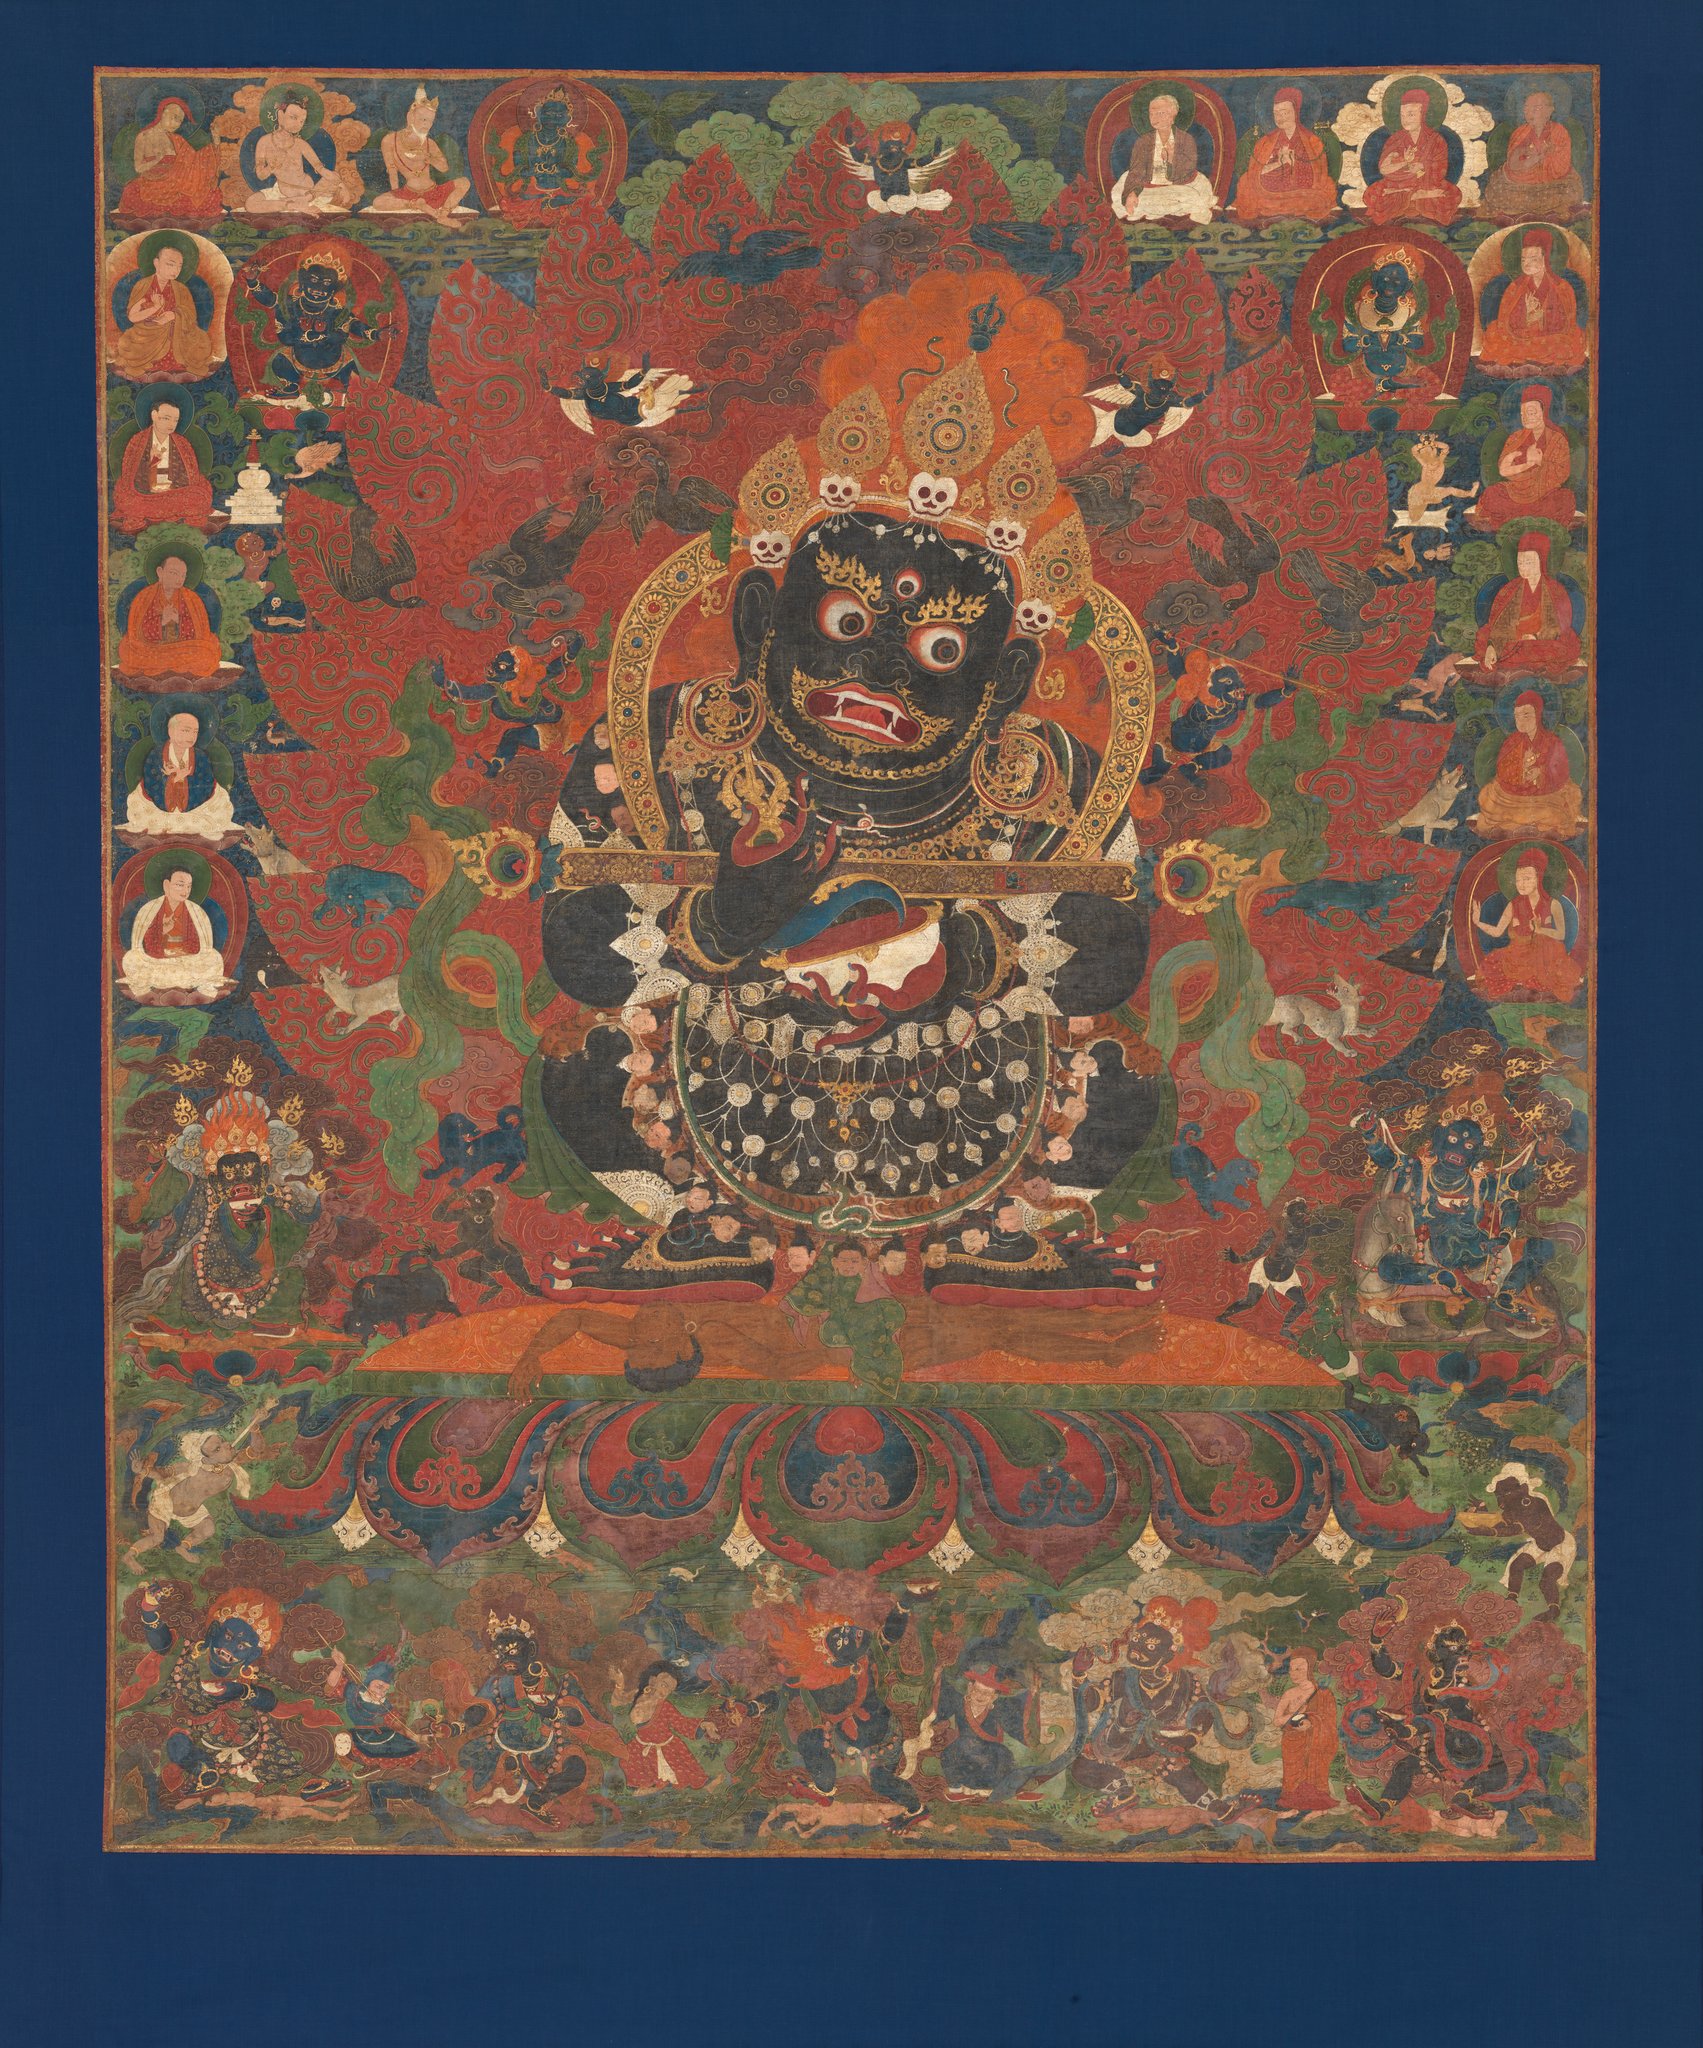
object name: thangka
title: Mahakala, Protector of the Tent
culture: tibetan, central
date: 1500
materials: textile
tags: buddhism,deities